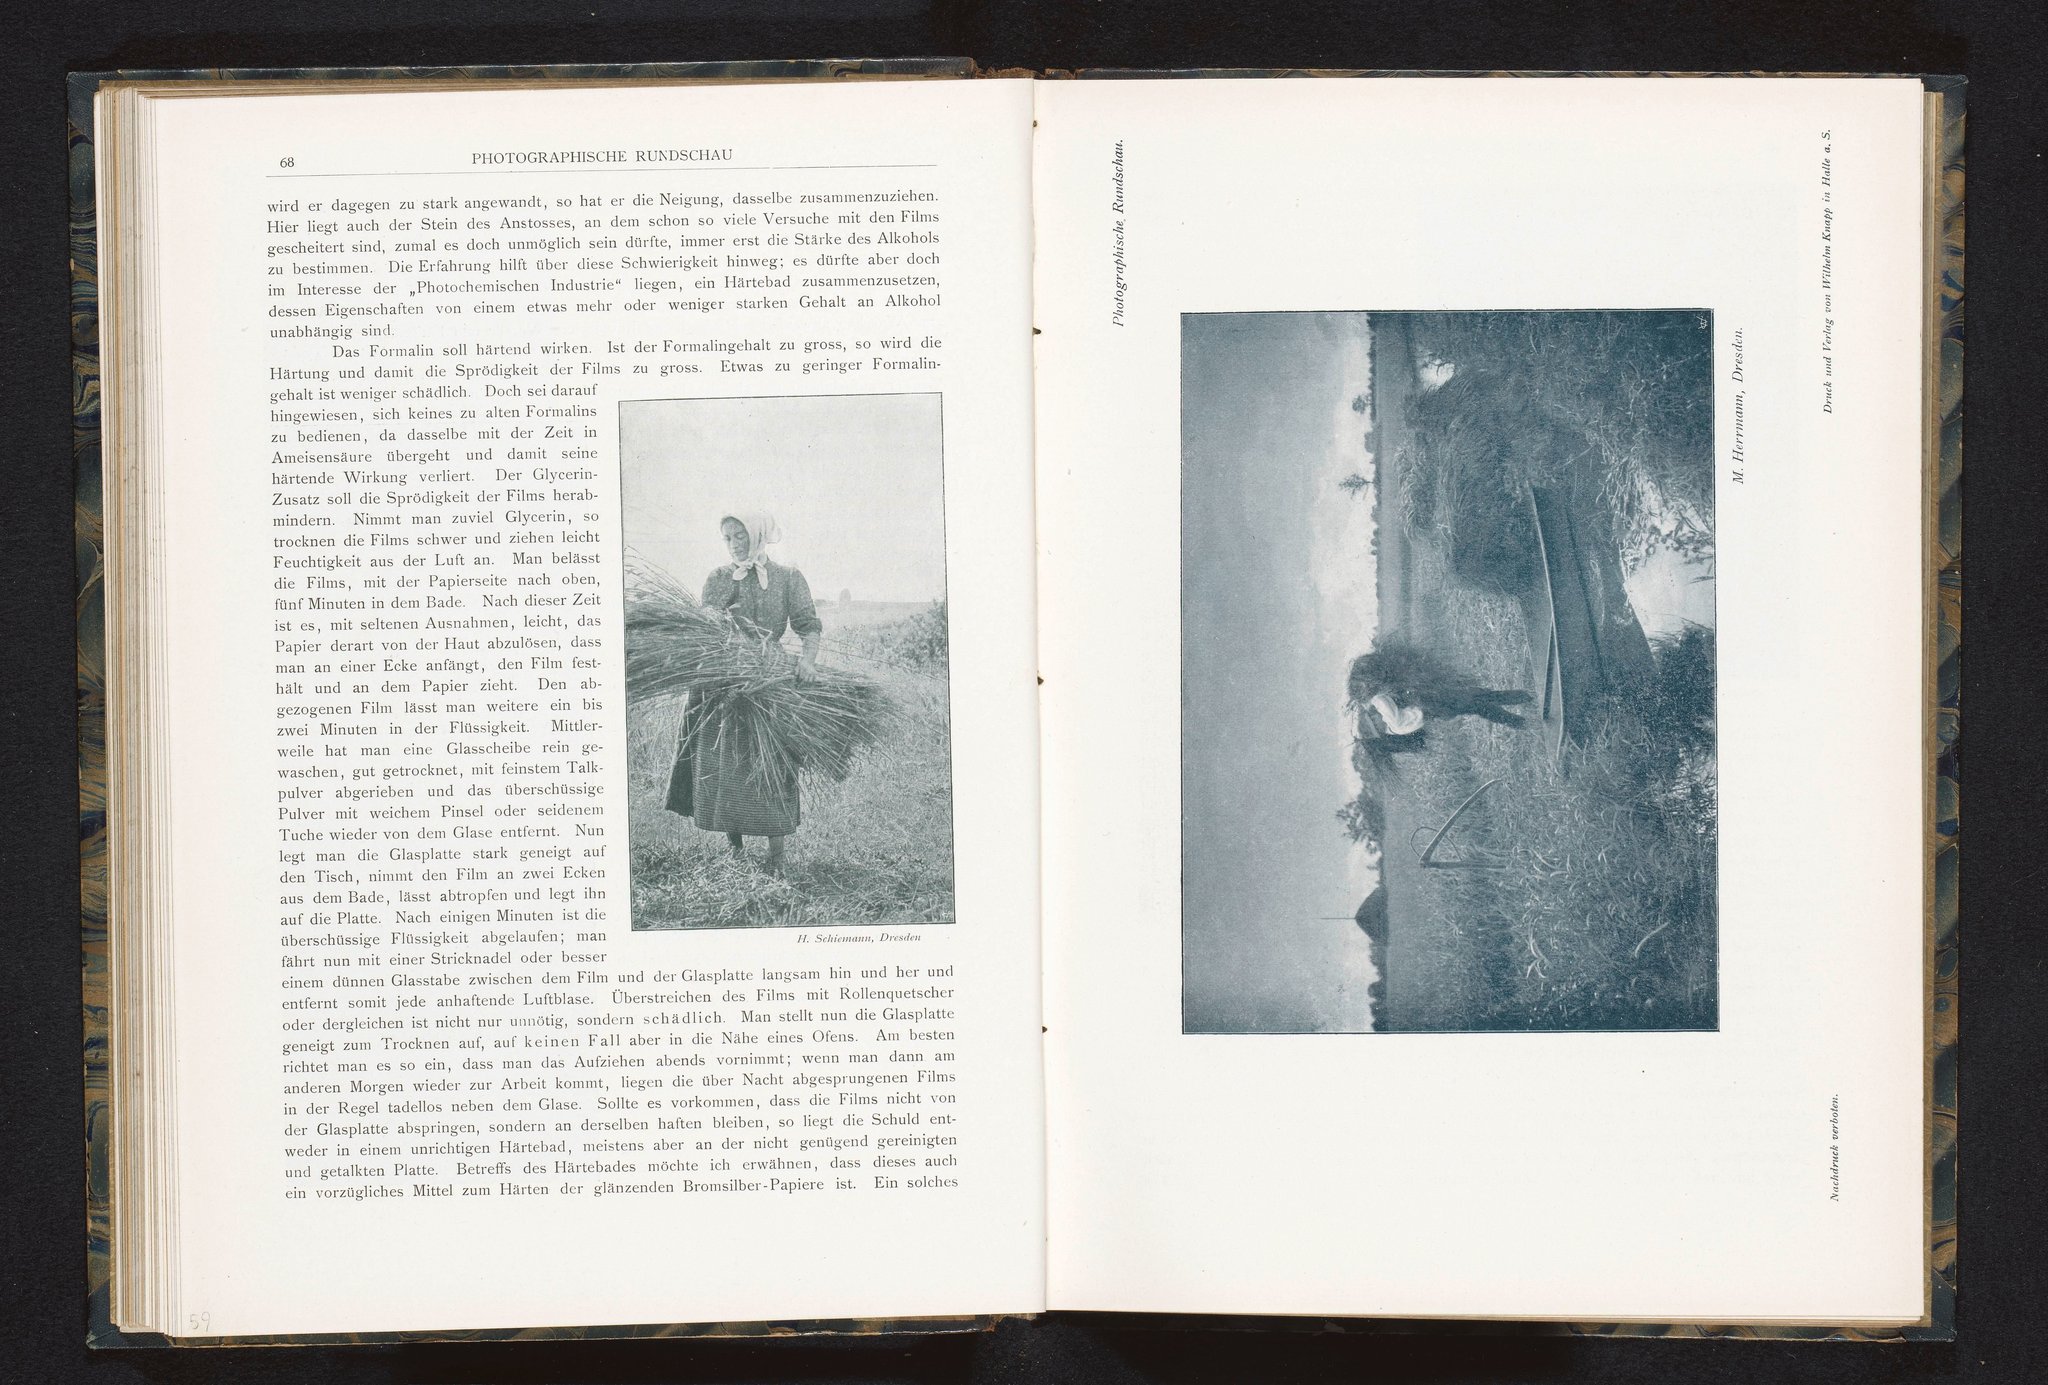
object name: photomechanical print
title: Gezicht op een onbekende vrouw met stro in haar handen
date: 1895-1900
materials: paper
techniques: autotype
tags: adult woman, agricultural products and by-products: straw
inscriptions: monogram: ‘WC’